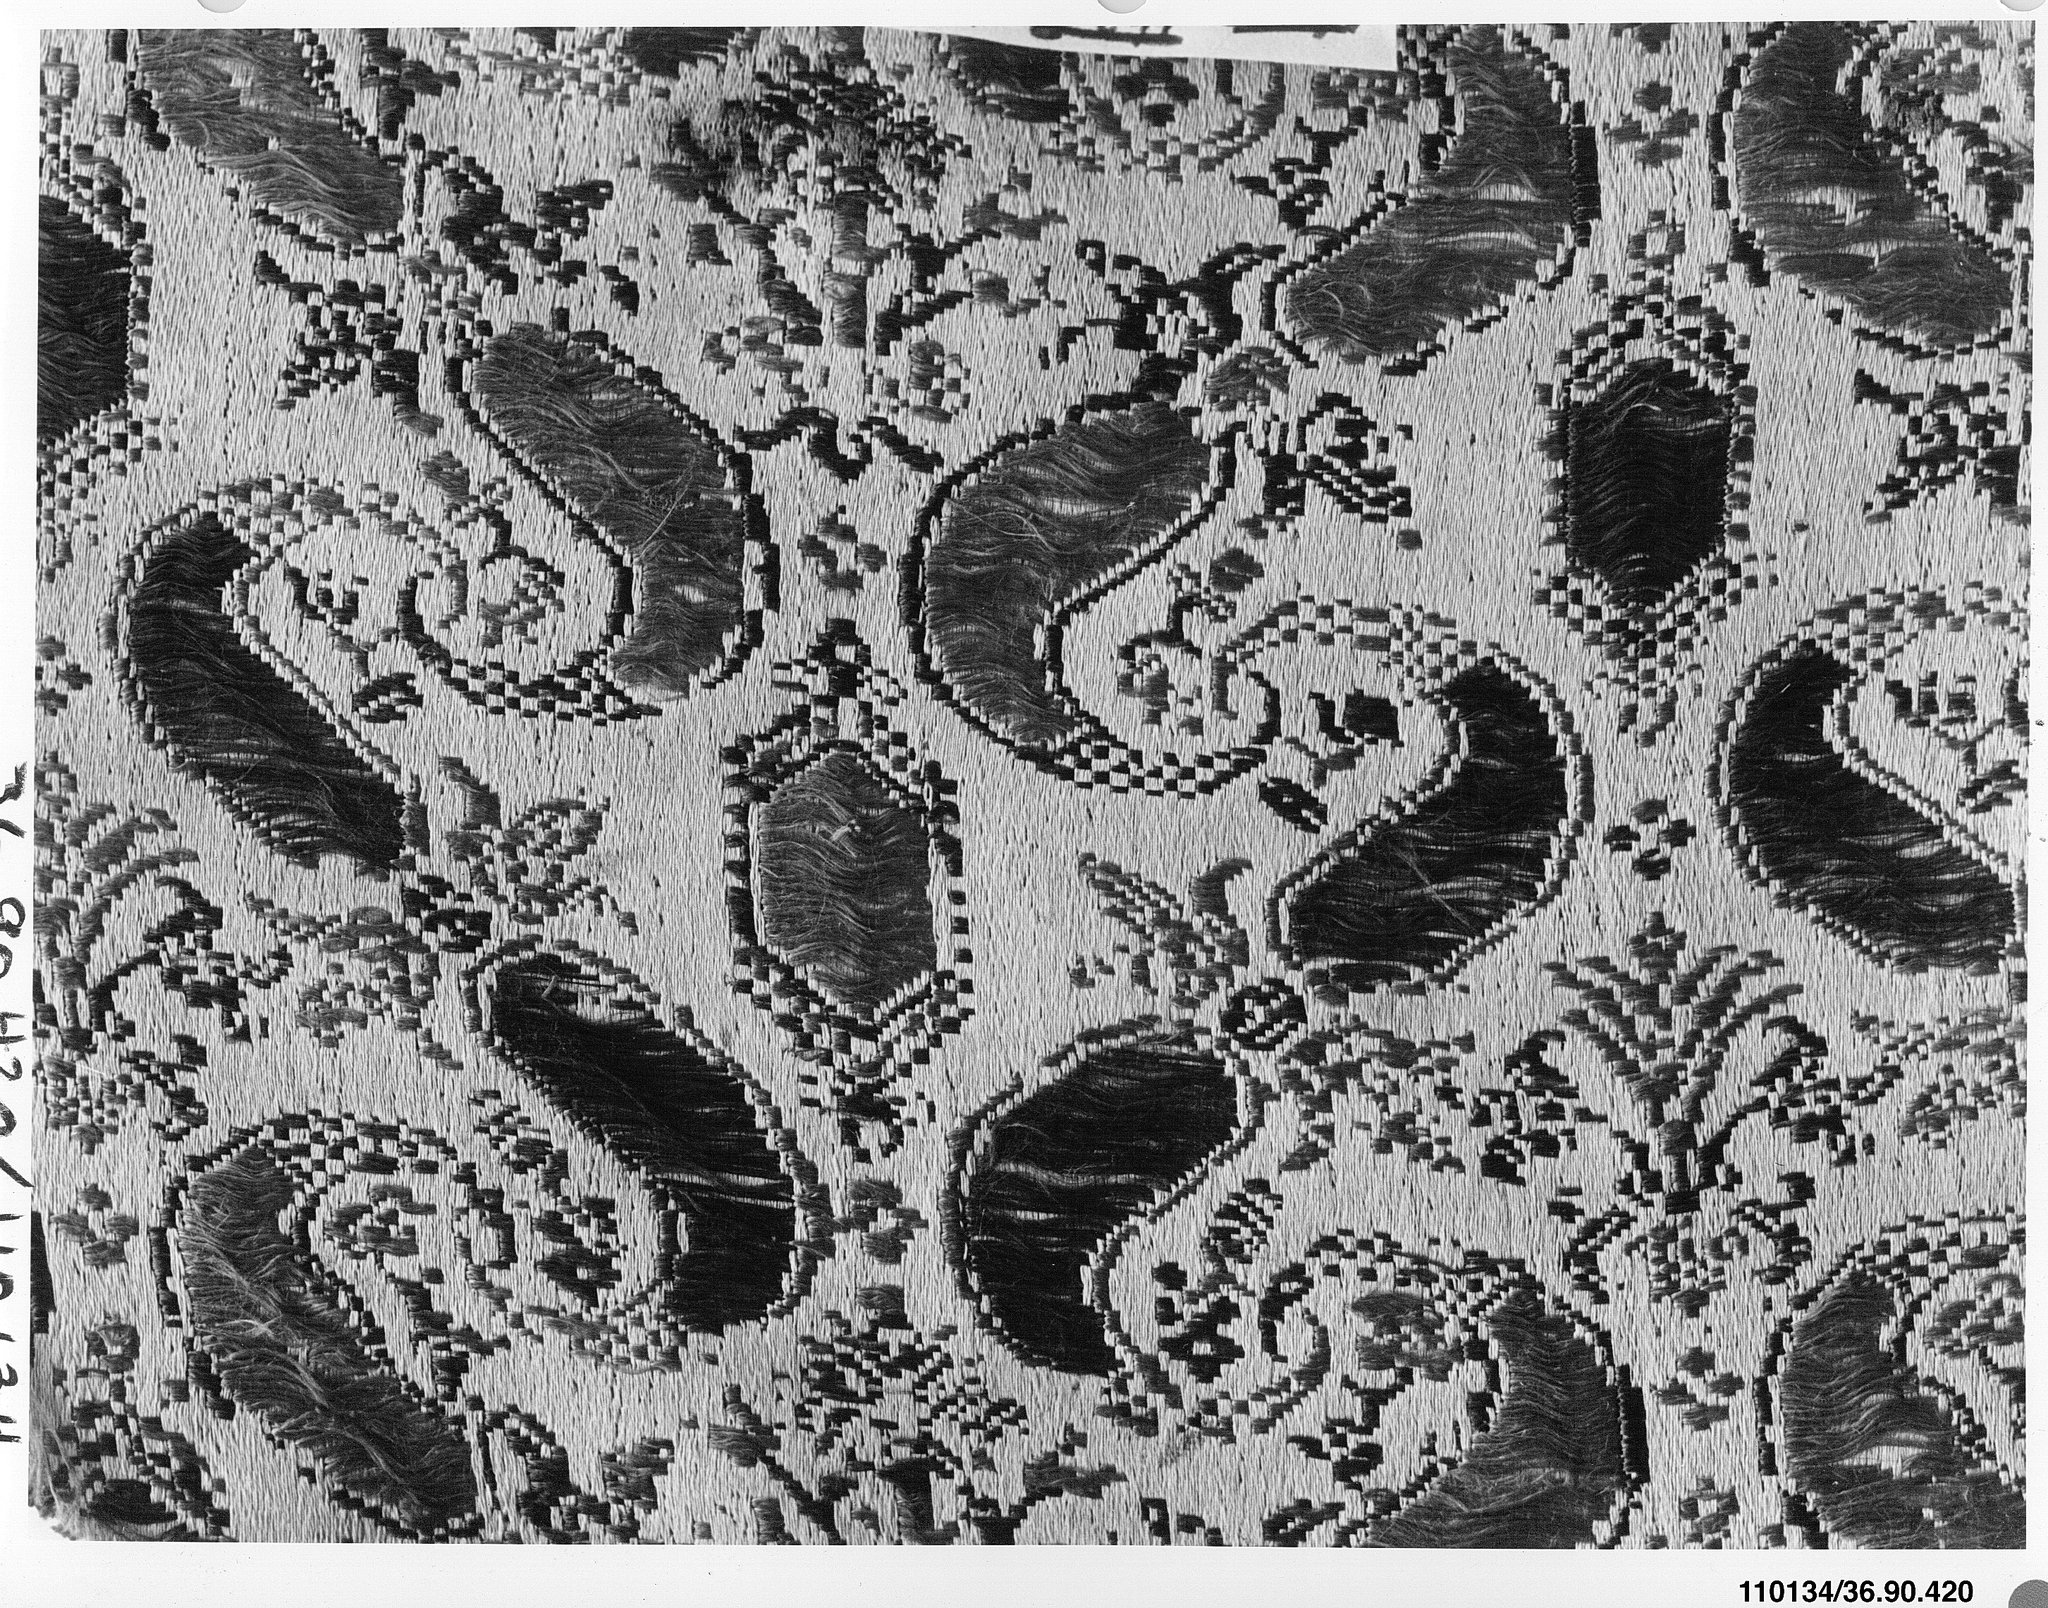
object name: piece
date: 1501-1700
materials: silk